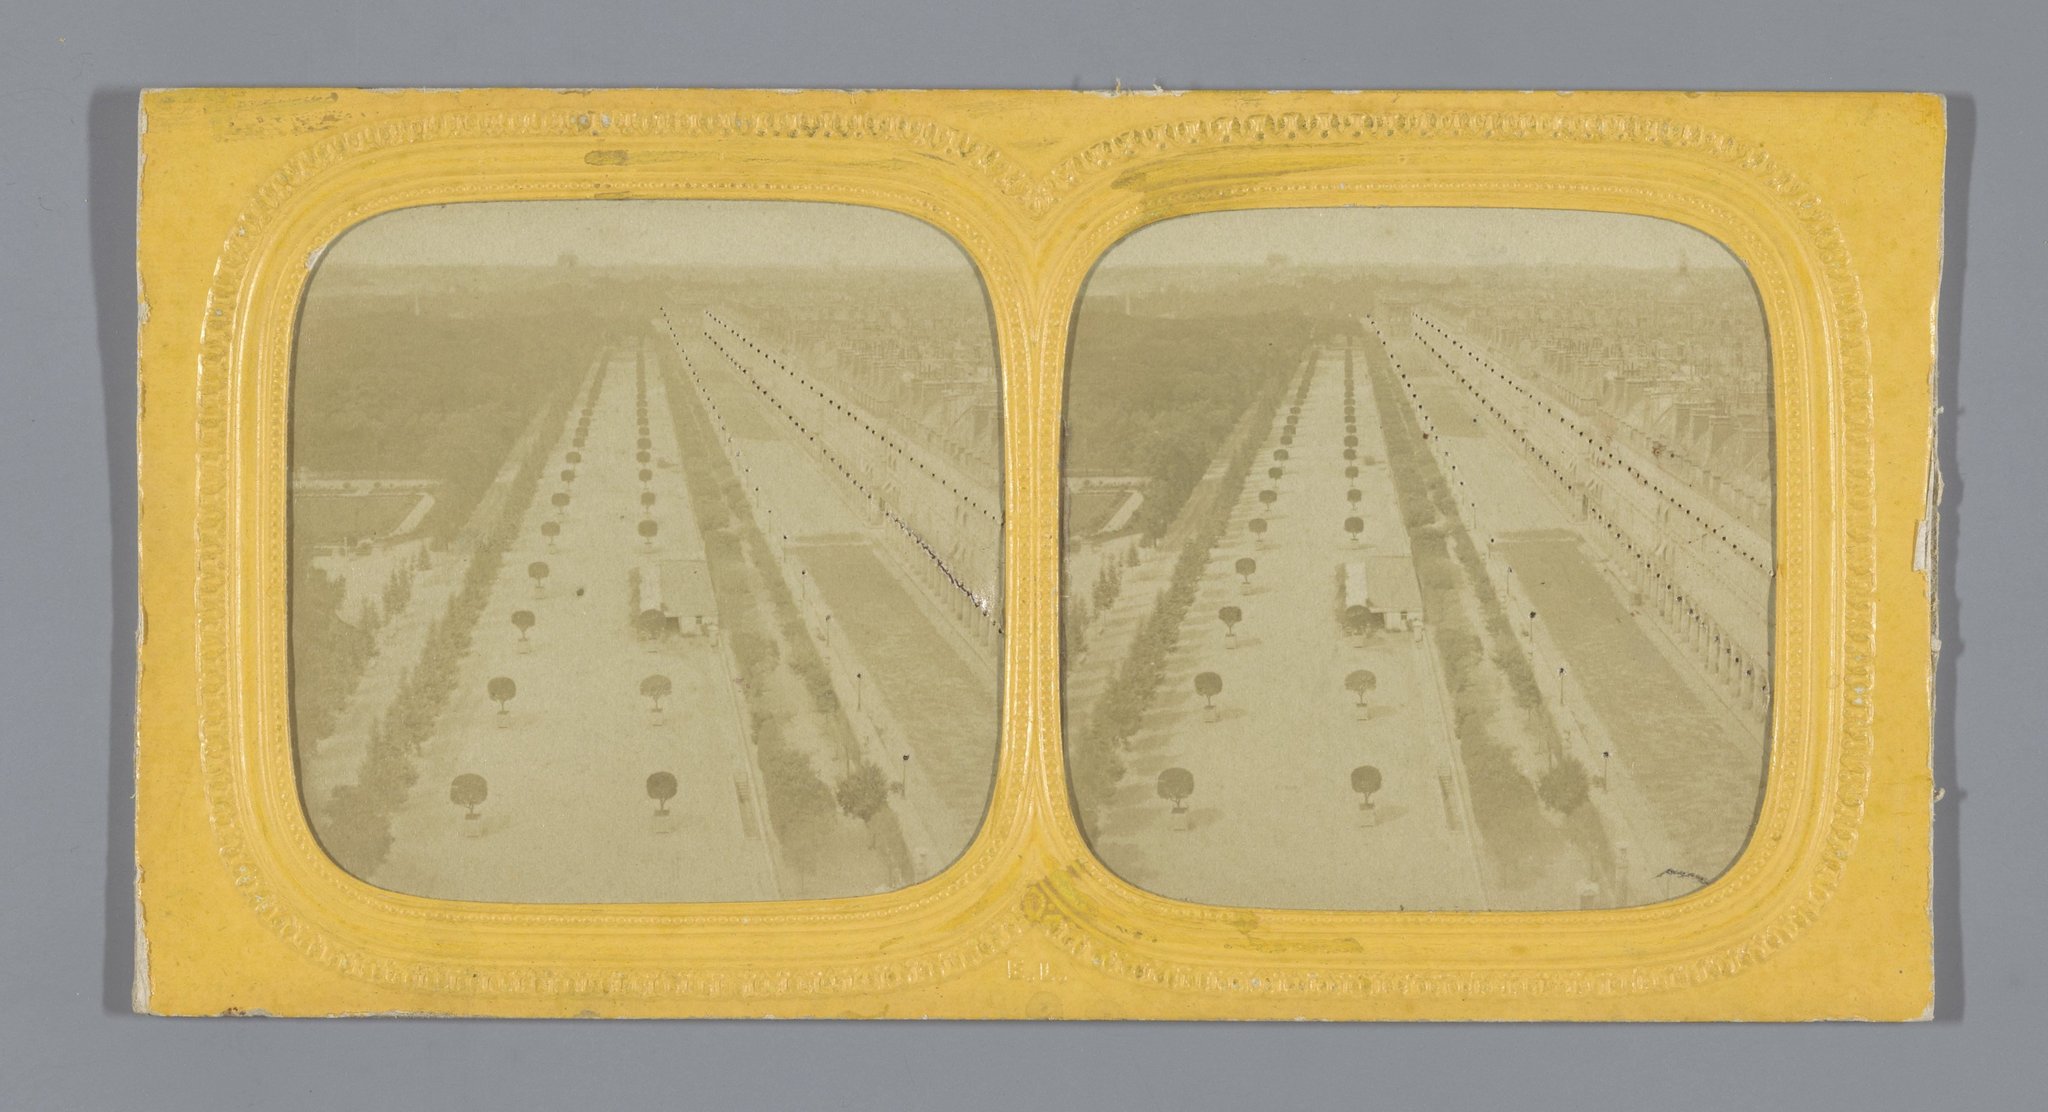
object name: tissue stereograph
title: Rue de Rivolie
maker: Anonymous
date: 1855-1875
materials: cardboard, paper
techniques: albumen print, hand coloring, perforating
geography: paris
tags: street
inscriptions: monogram: ‘E.L.’